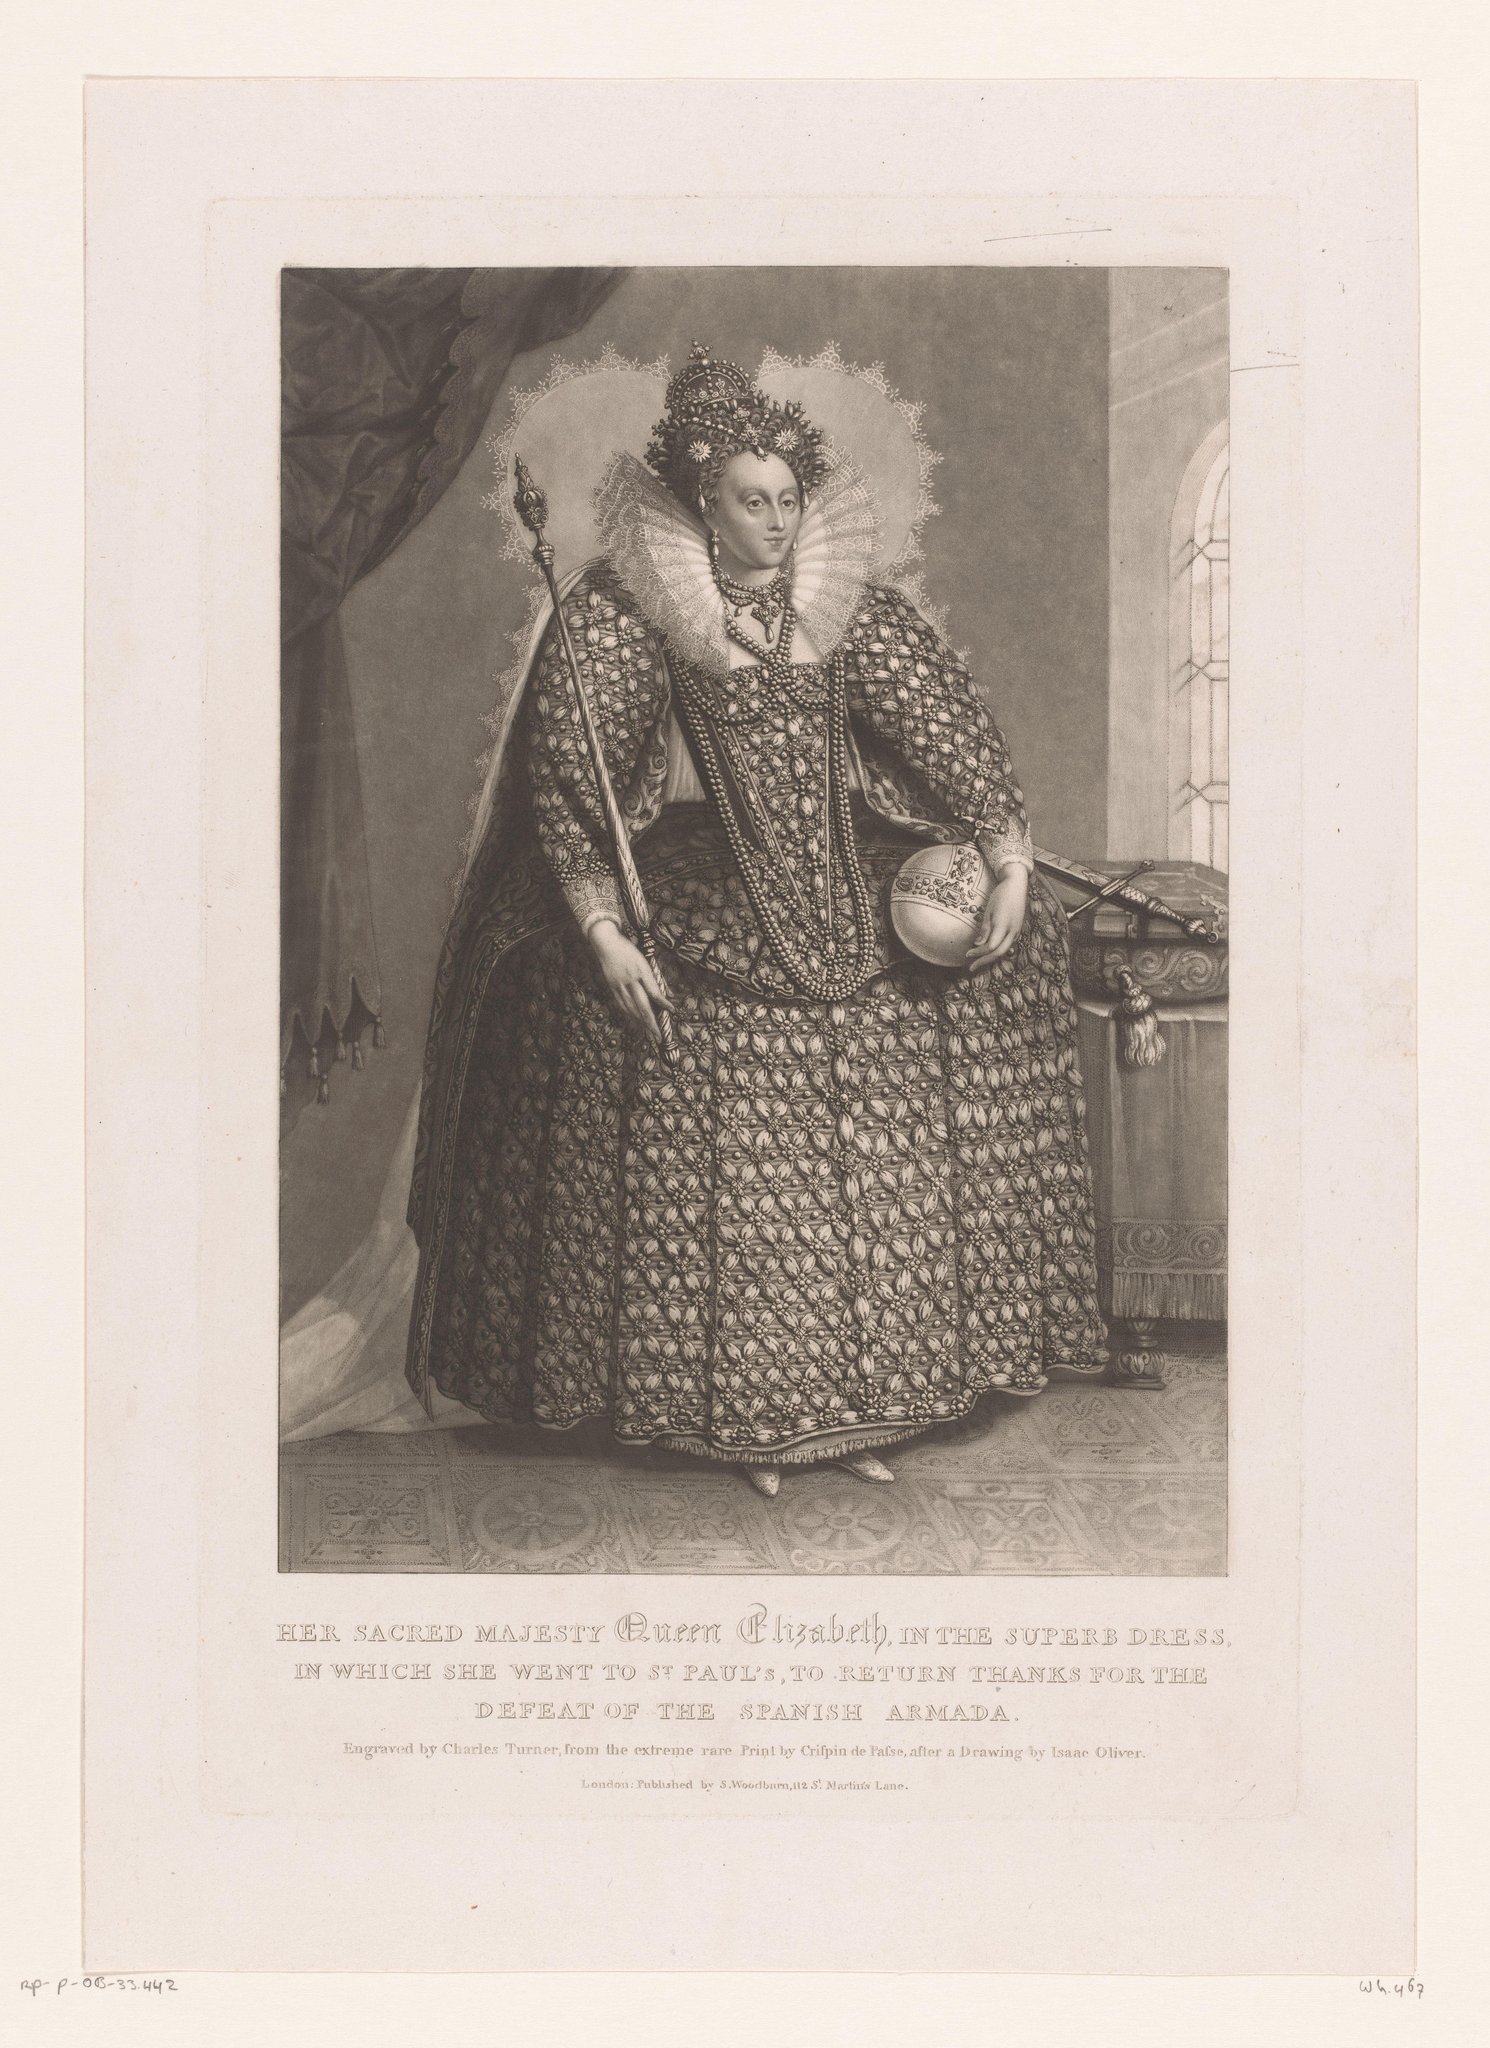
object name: print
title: Portret van Elizabeth I Tudor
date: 1816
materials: paper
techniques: etching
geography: london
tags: historical persons - bb - woman, queen, orb (symbol of sovereignty; sphere with cross on top) - bb - female ruler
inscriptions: collector's mark: Lugt 12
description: Serie van vijftien kopieën van oude prenten, gemaakt door Charles Turner, Richard Earlom en Robert Dunkarton. Door Samuel Woodburn in 1816 gebonden uitgegeven. In 1830 nogmaals uitgegeven door J.B. Nichols & Son.